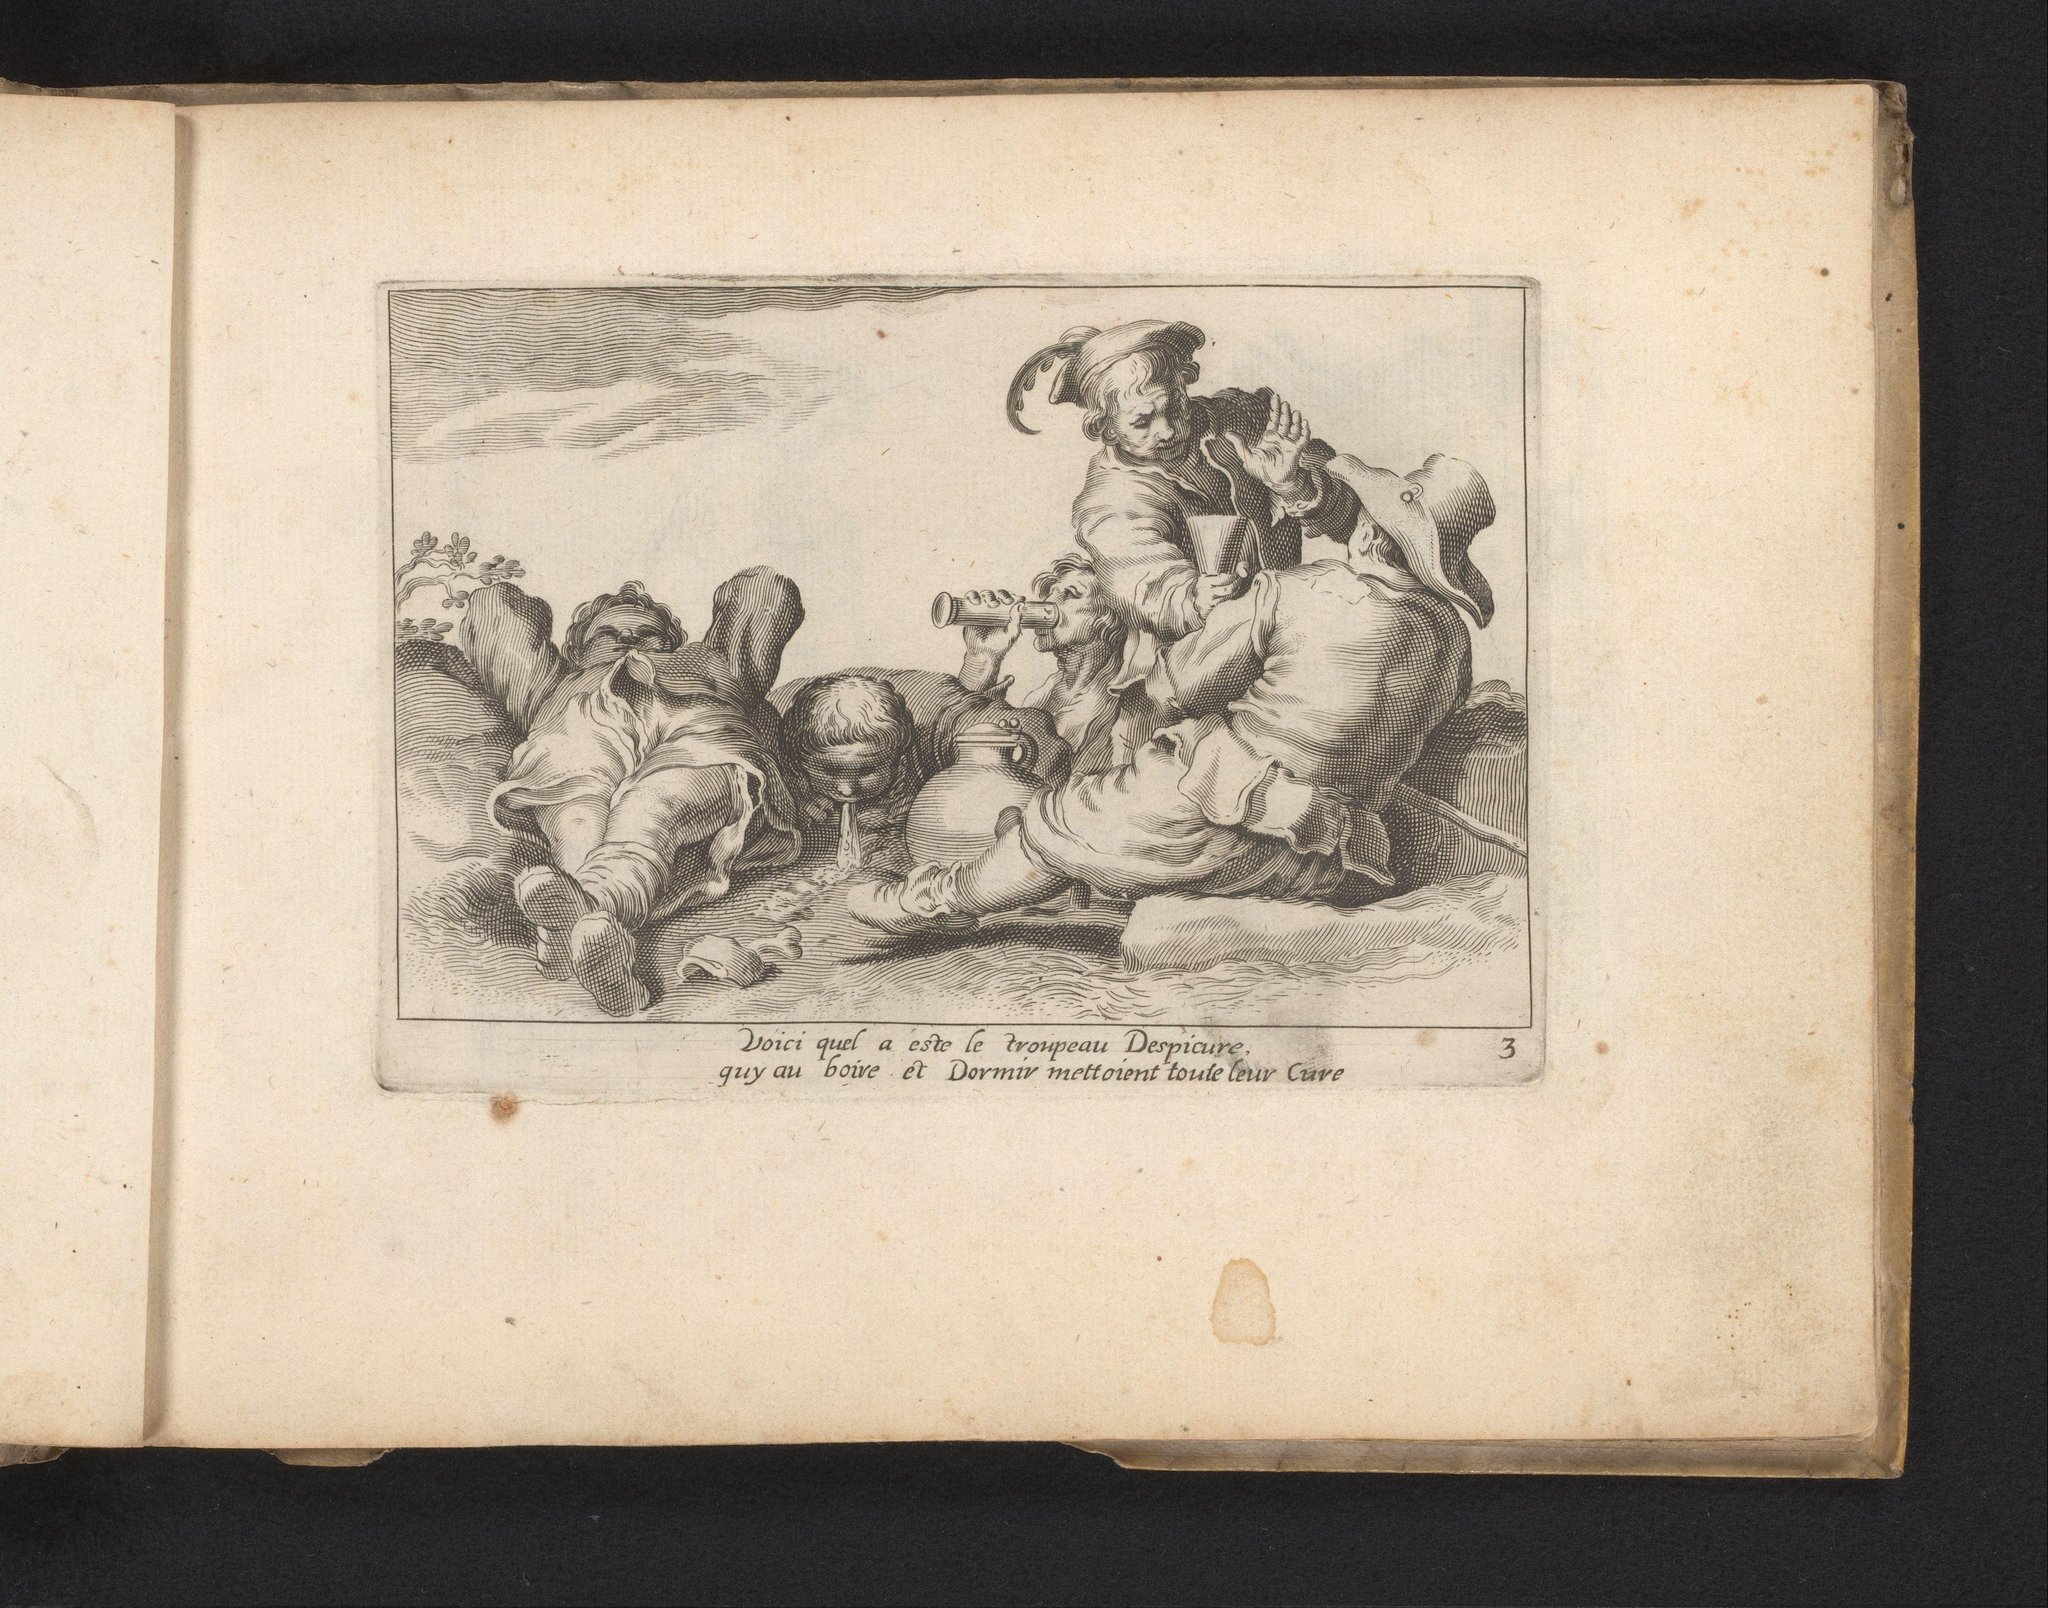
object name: print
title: Vijf dronkaards in een landschap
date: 1606-1669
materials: paper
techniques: etching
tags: drunkard, vomiting, sleeping on the ground - bb - out of doors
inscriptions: collector's mark: ‘Bibliotheek/ Rijksmuseum/ Amsterdam’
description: Een van de mannen slaapt, een ander braakt, de rest drinkt. Deze prent maakt deel uit van een album.